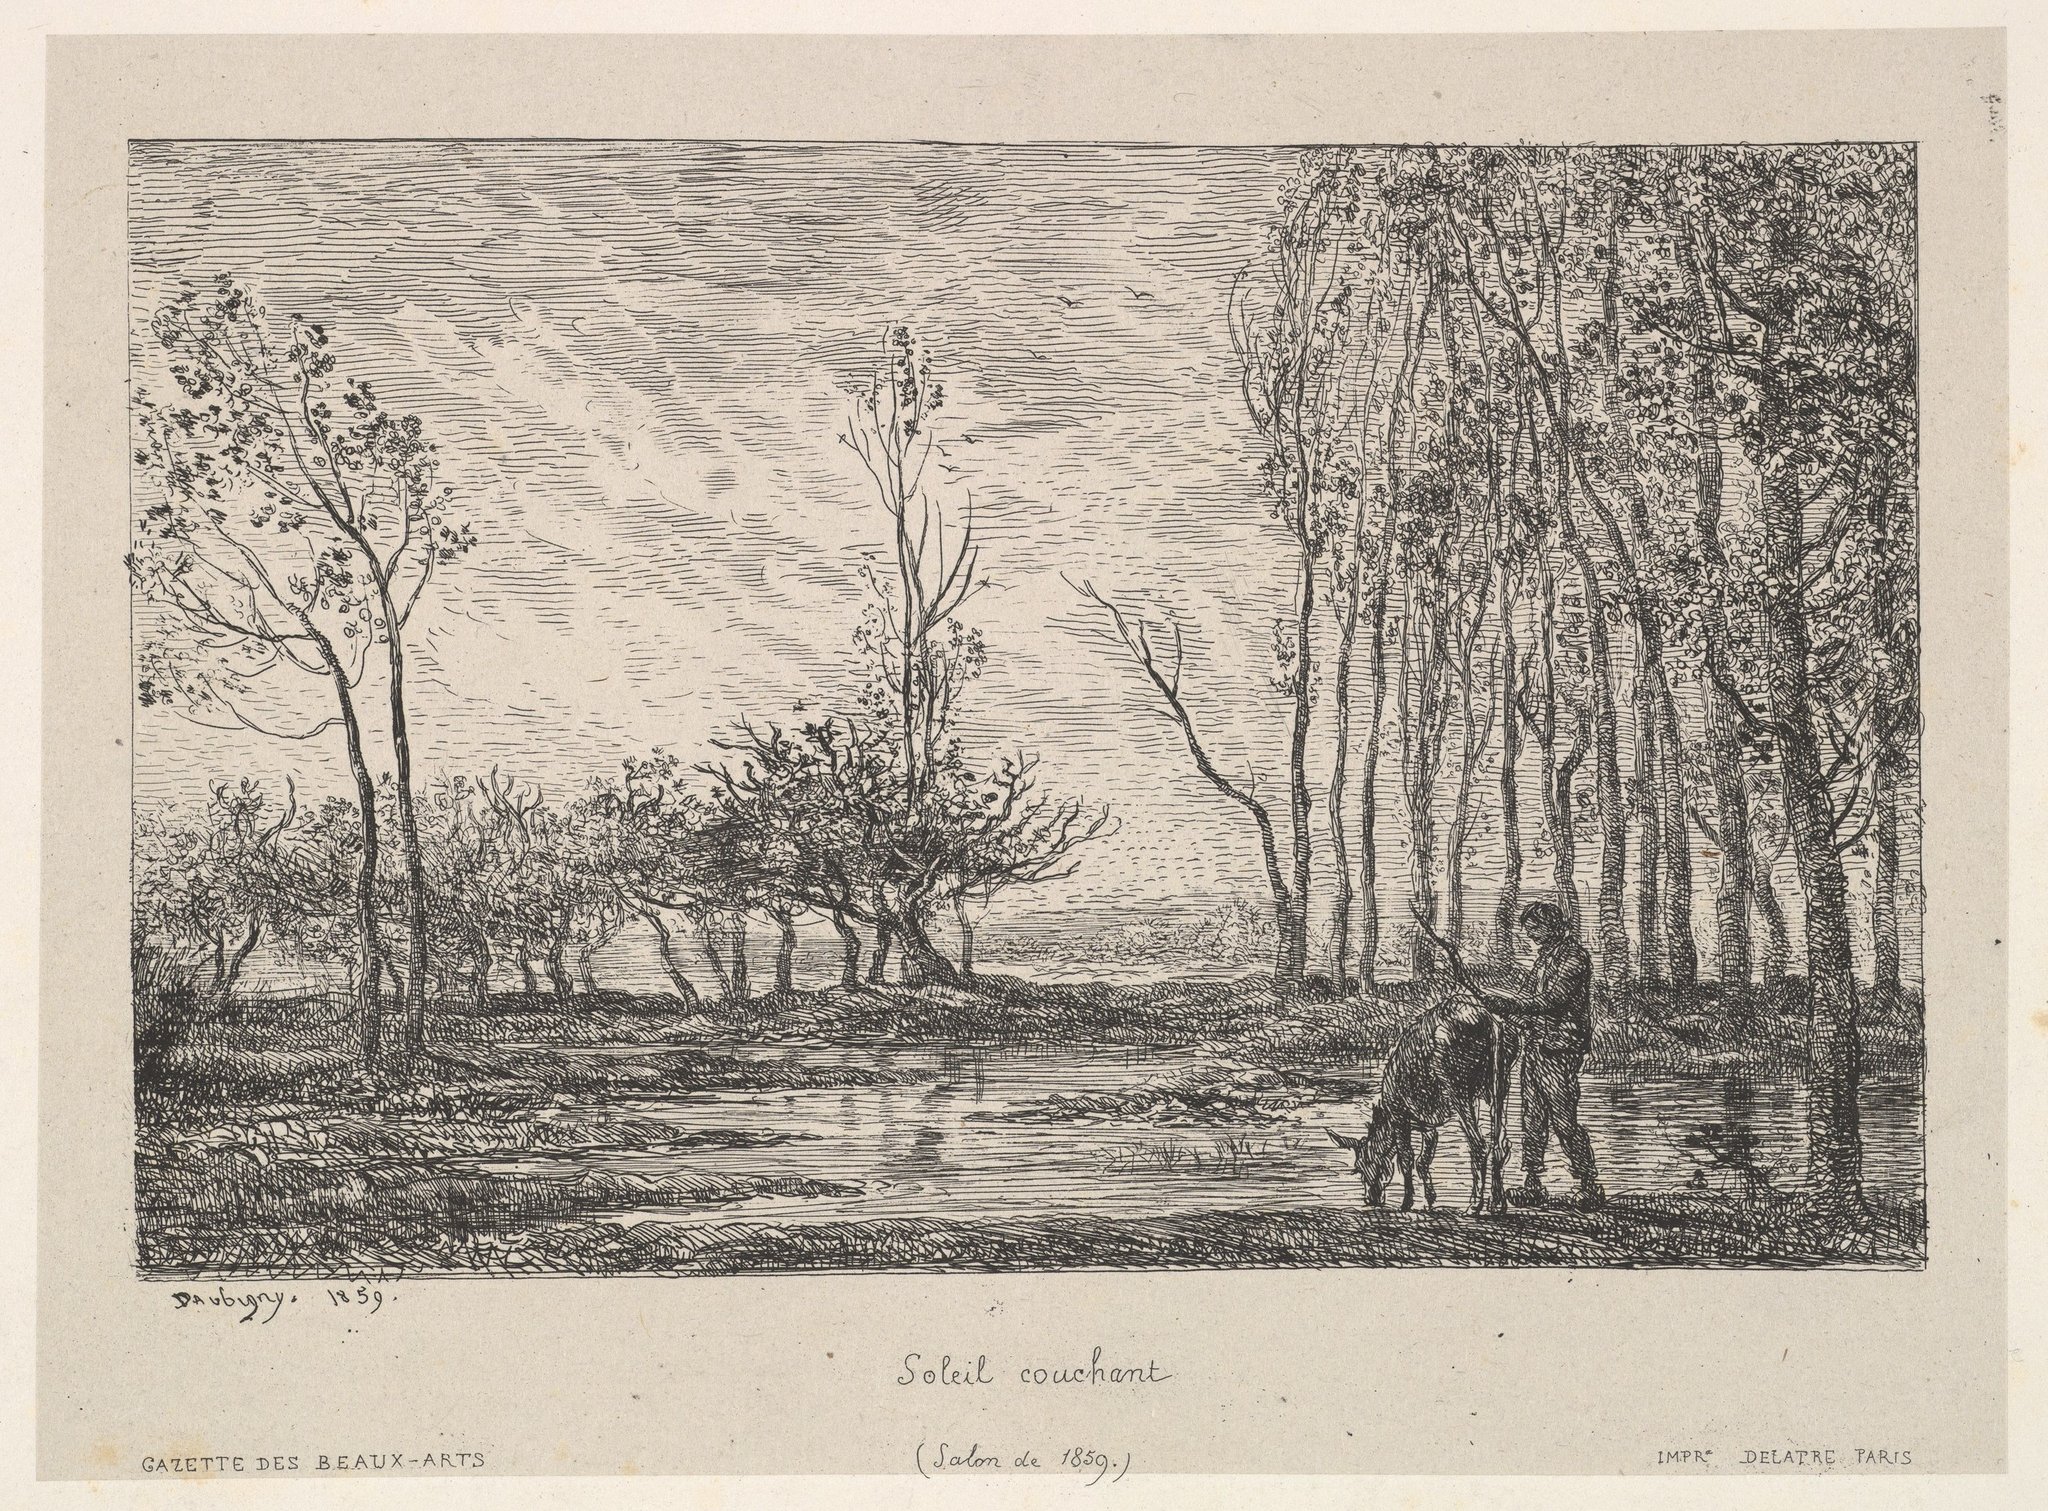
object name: print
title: Sunset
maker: charles-françois daubigny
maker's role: artist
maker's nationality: french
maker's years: 1817-1878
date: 1859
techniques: etching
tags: animals,men,trees,evening